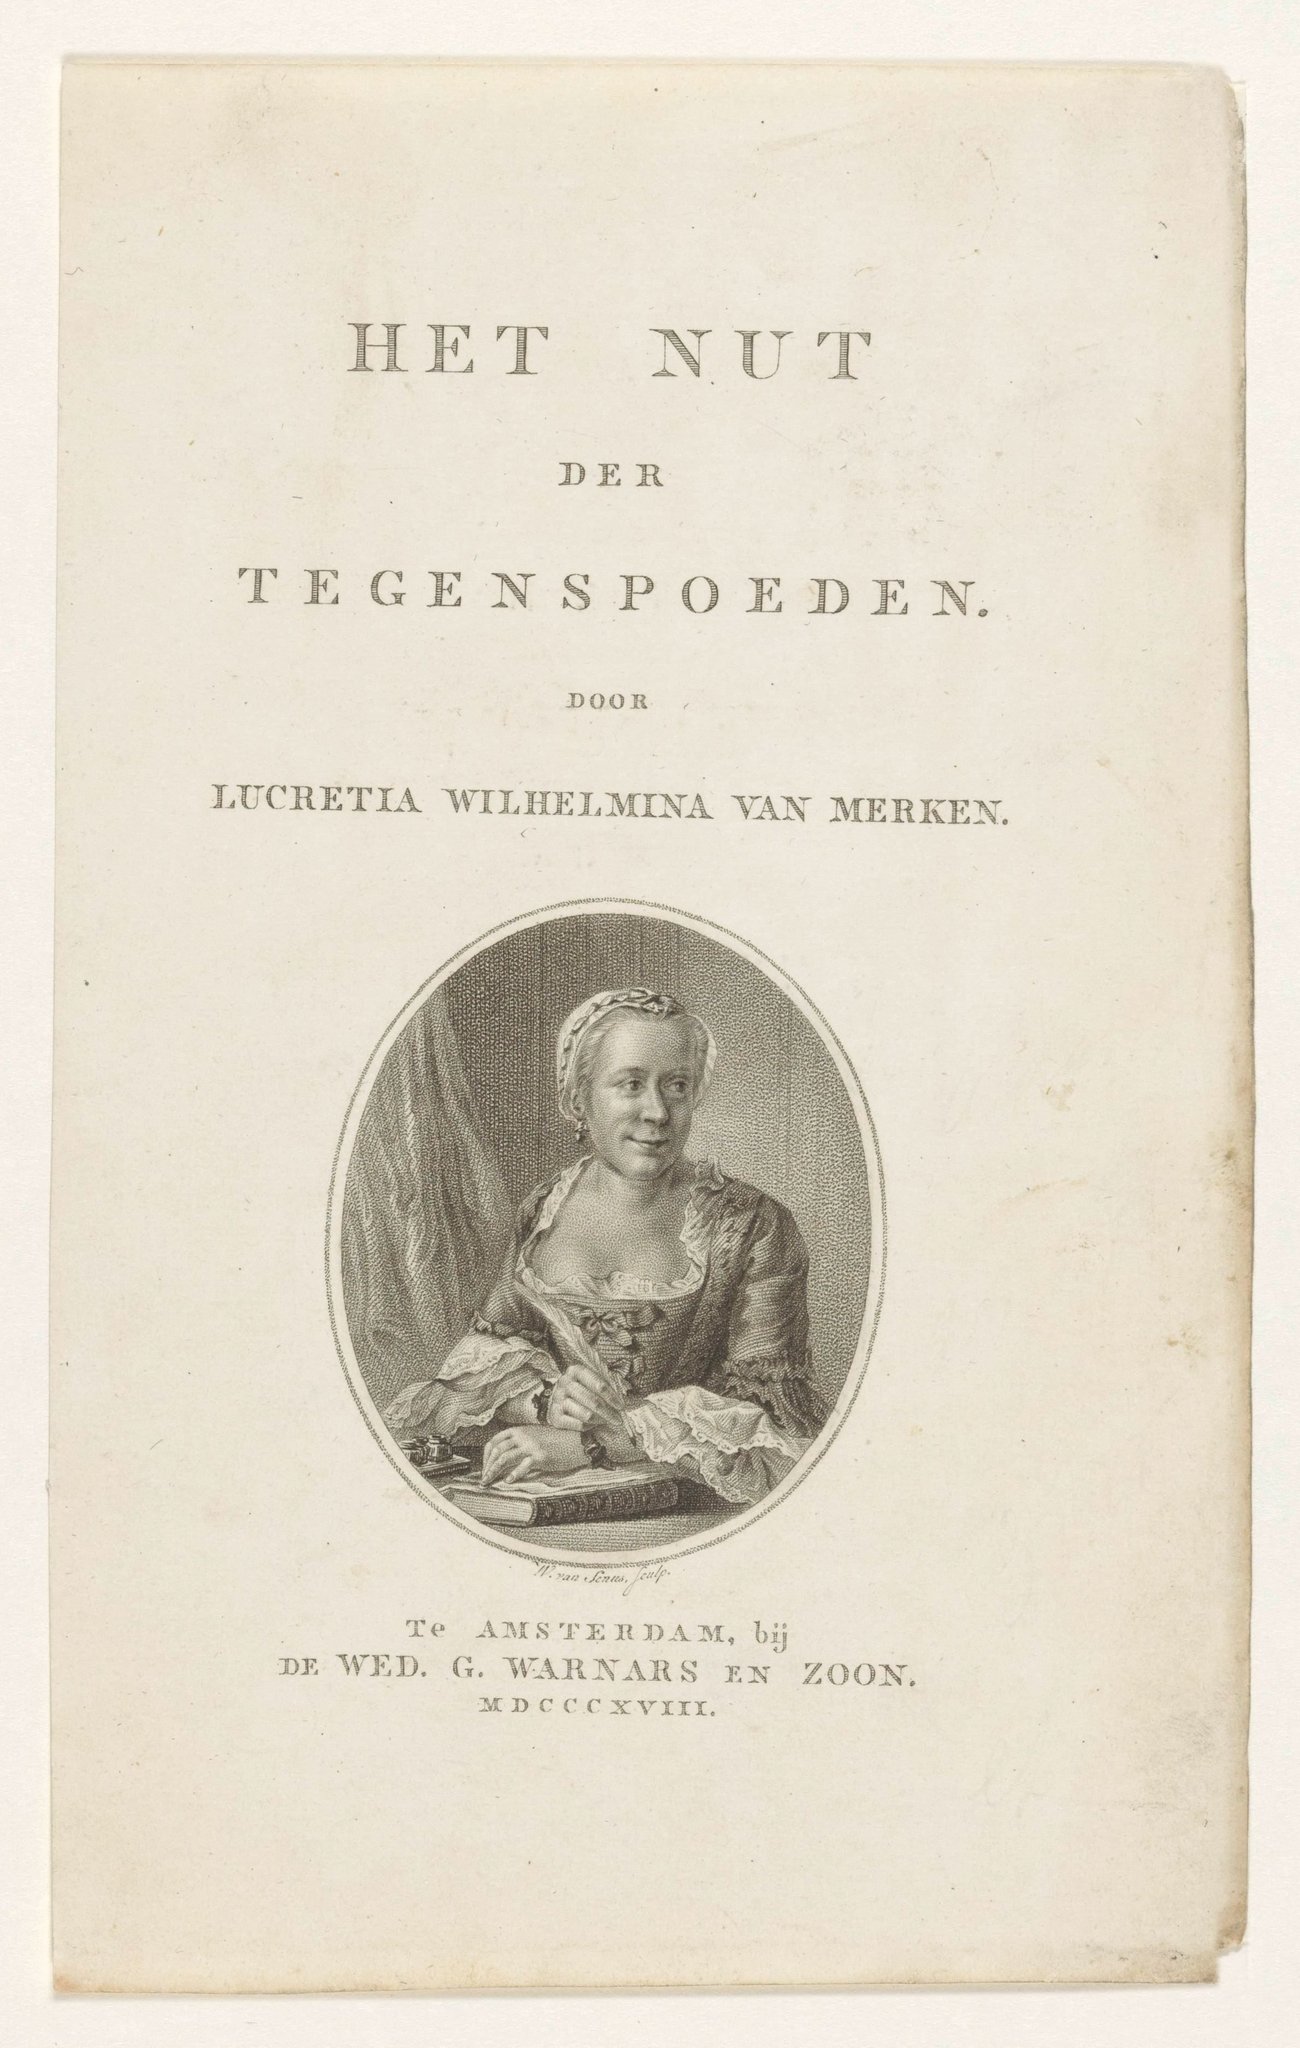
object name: titelblad, titelpagina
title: Titelpagina voor: Lucretia Wilhelmina van Merken, Het nut der tegenspoeden, 1818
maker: willem van senus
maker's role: painter, print maker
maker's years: 1773-1851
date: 1818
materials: paper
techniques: etching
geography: amsterdam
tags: amsterdam, leiden, lucretia wilhelmina van merken, portrait of a writer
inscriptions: collector's mark: Lugt 2228, collector's mark: Lugt 2760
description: Titelpagina voor: Merken, Lucretia Wilhelmina van. Het nut der tegenspoeden. Amsterdam: Warnars & zoon, weduwe Gerrit, 1818.